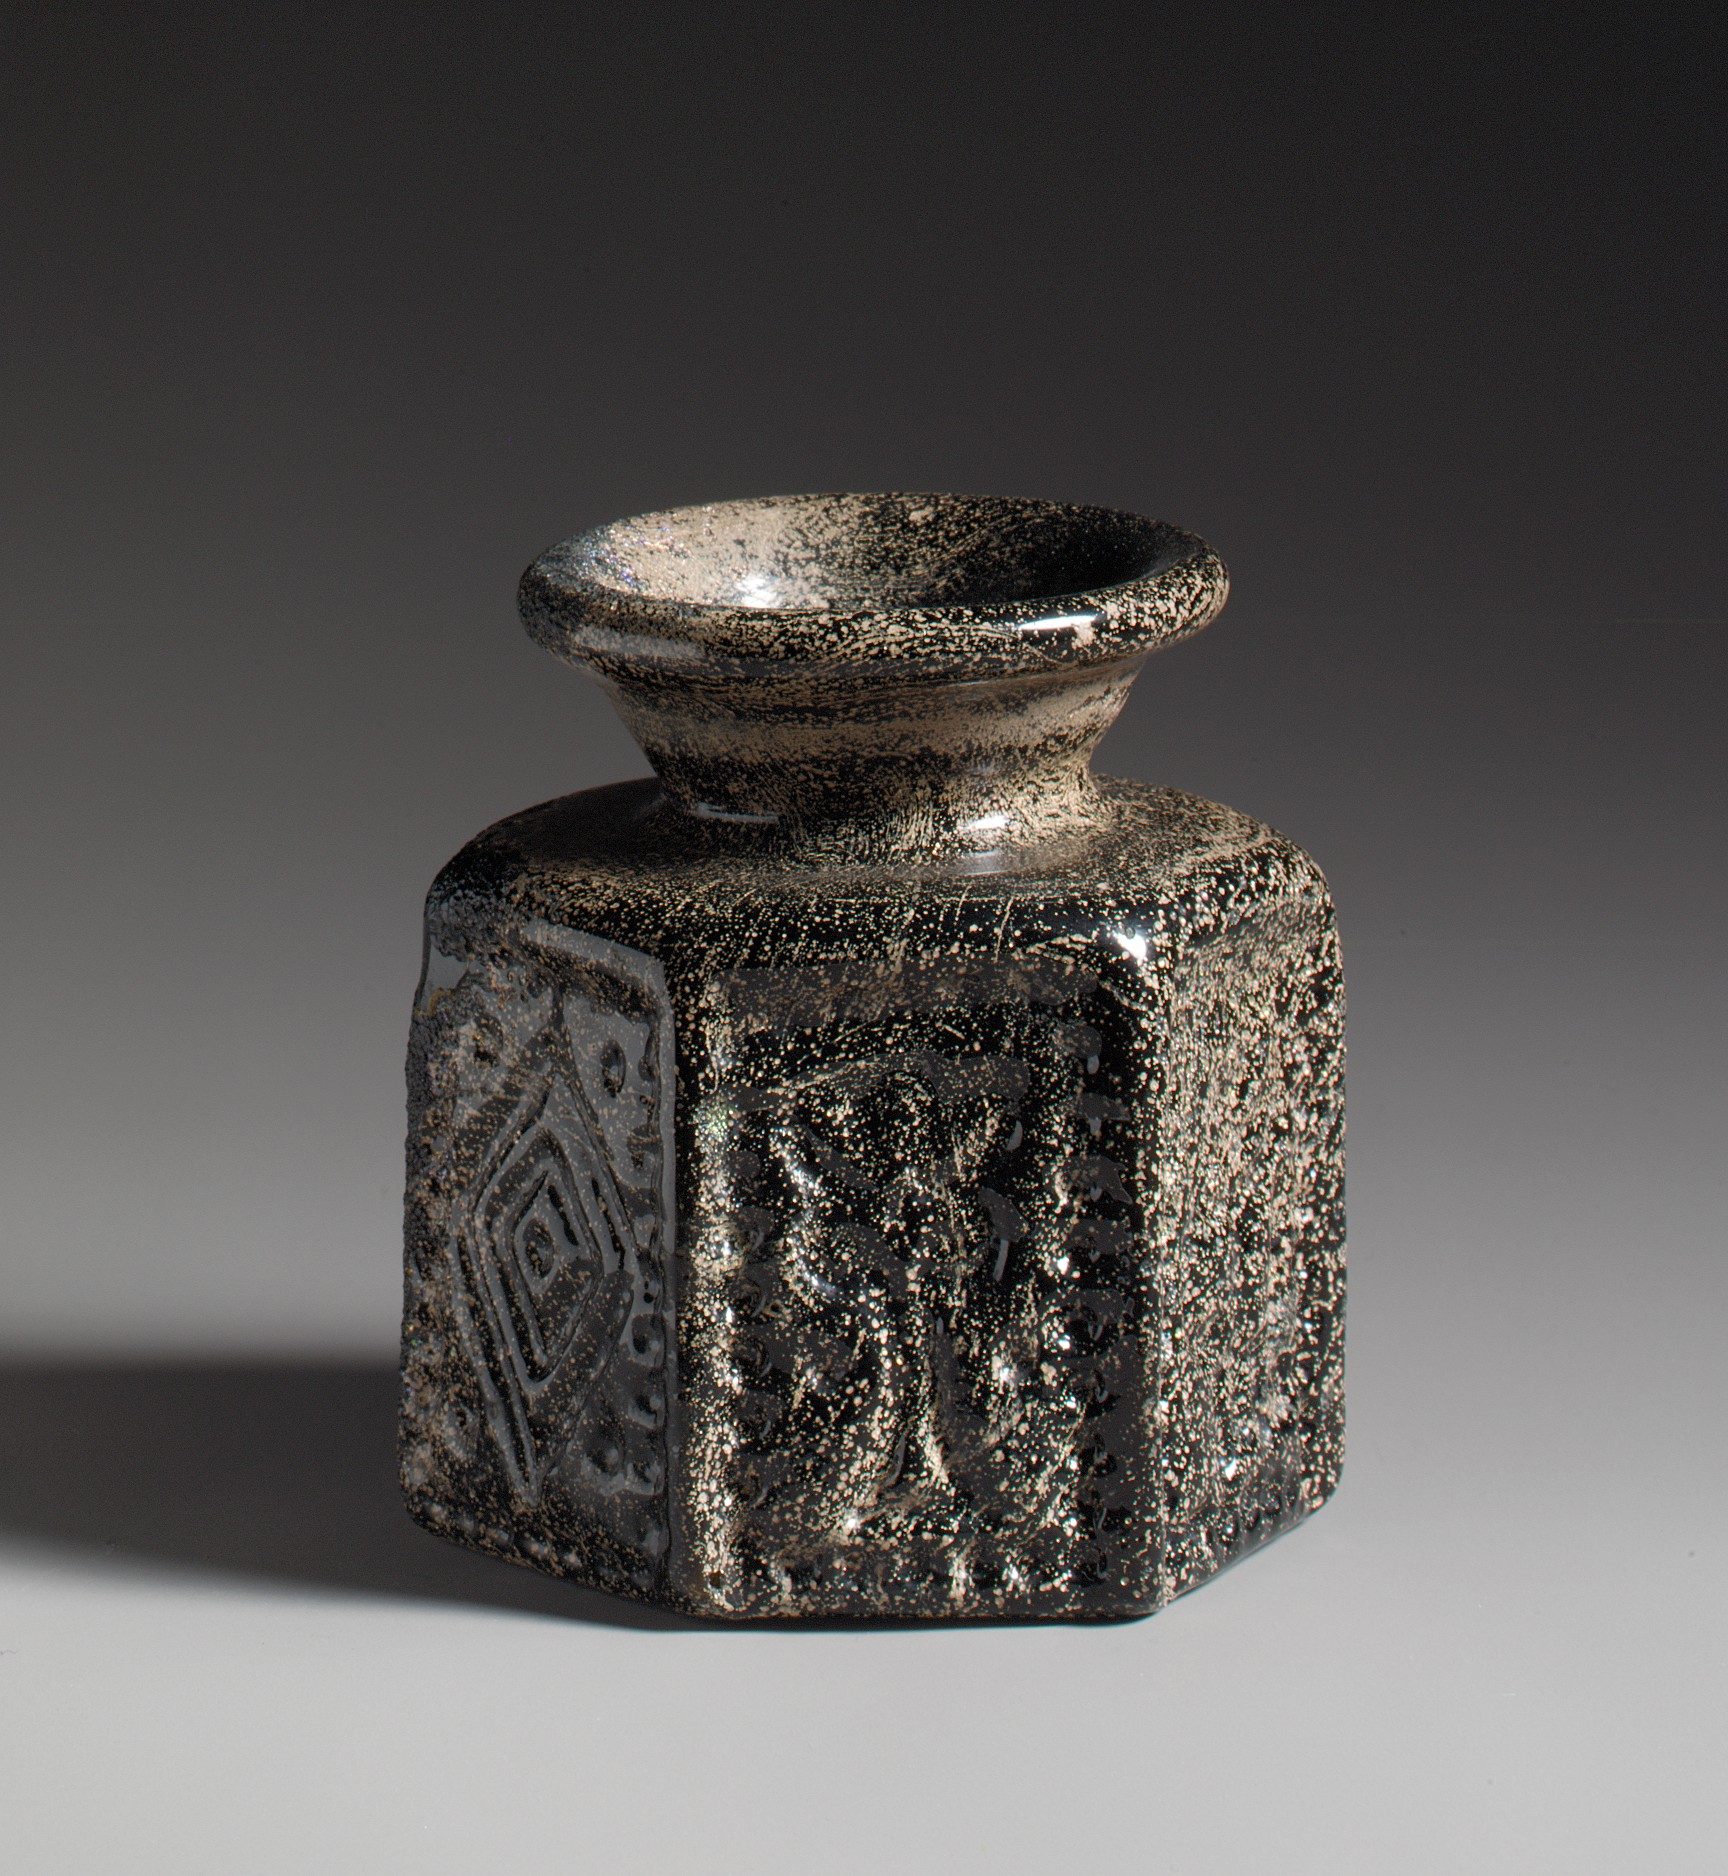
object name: jar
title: Hexagonal Pilgrim's Jar with Jewish Symbol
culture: byzantine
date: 578-636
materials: glass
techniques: glassblowing